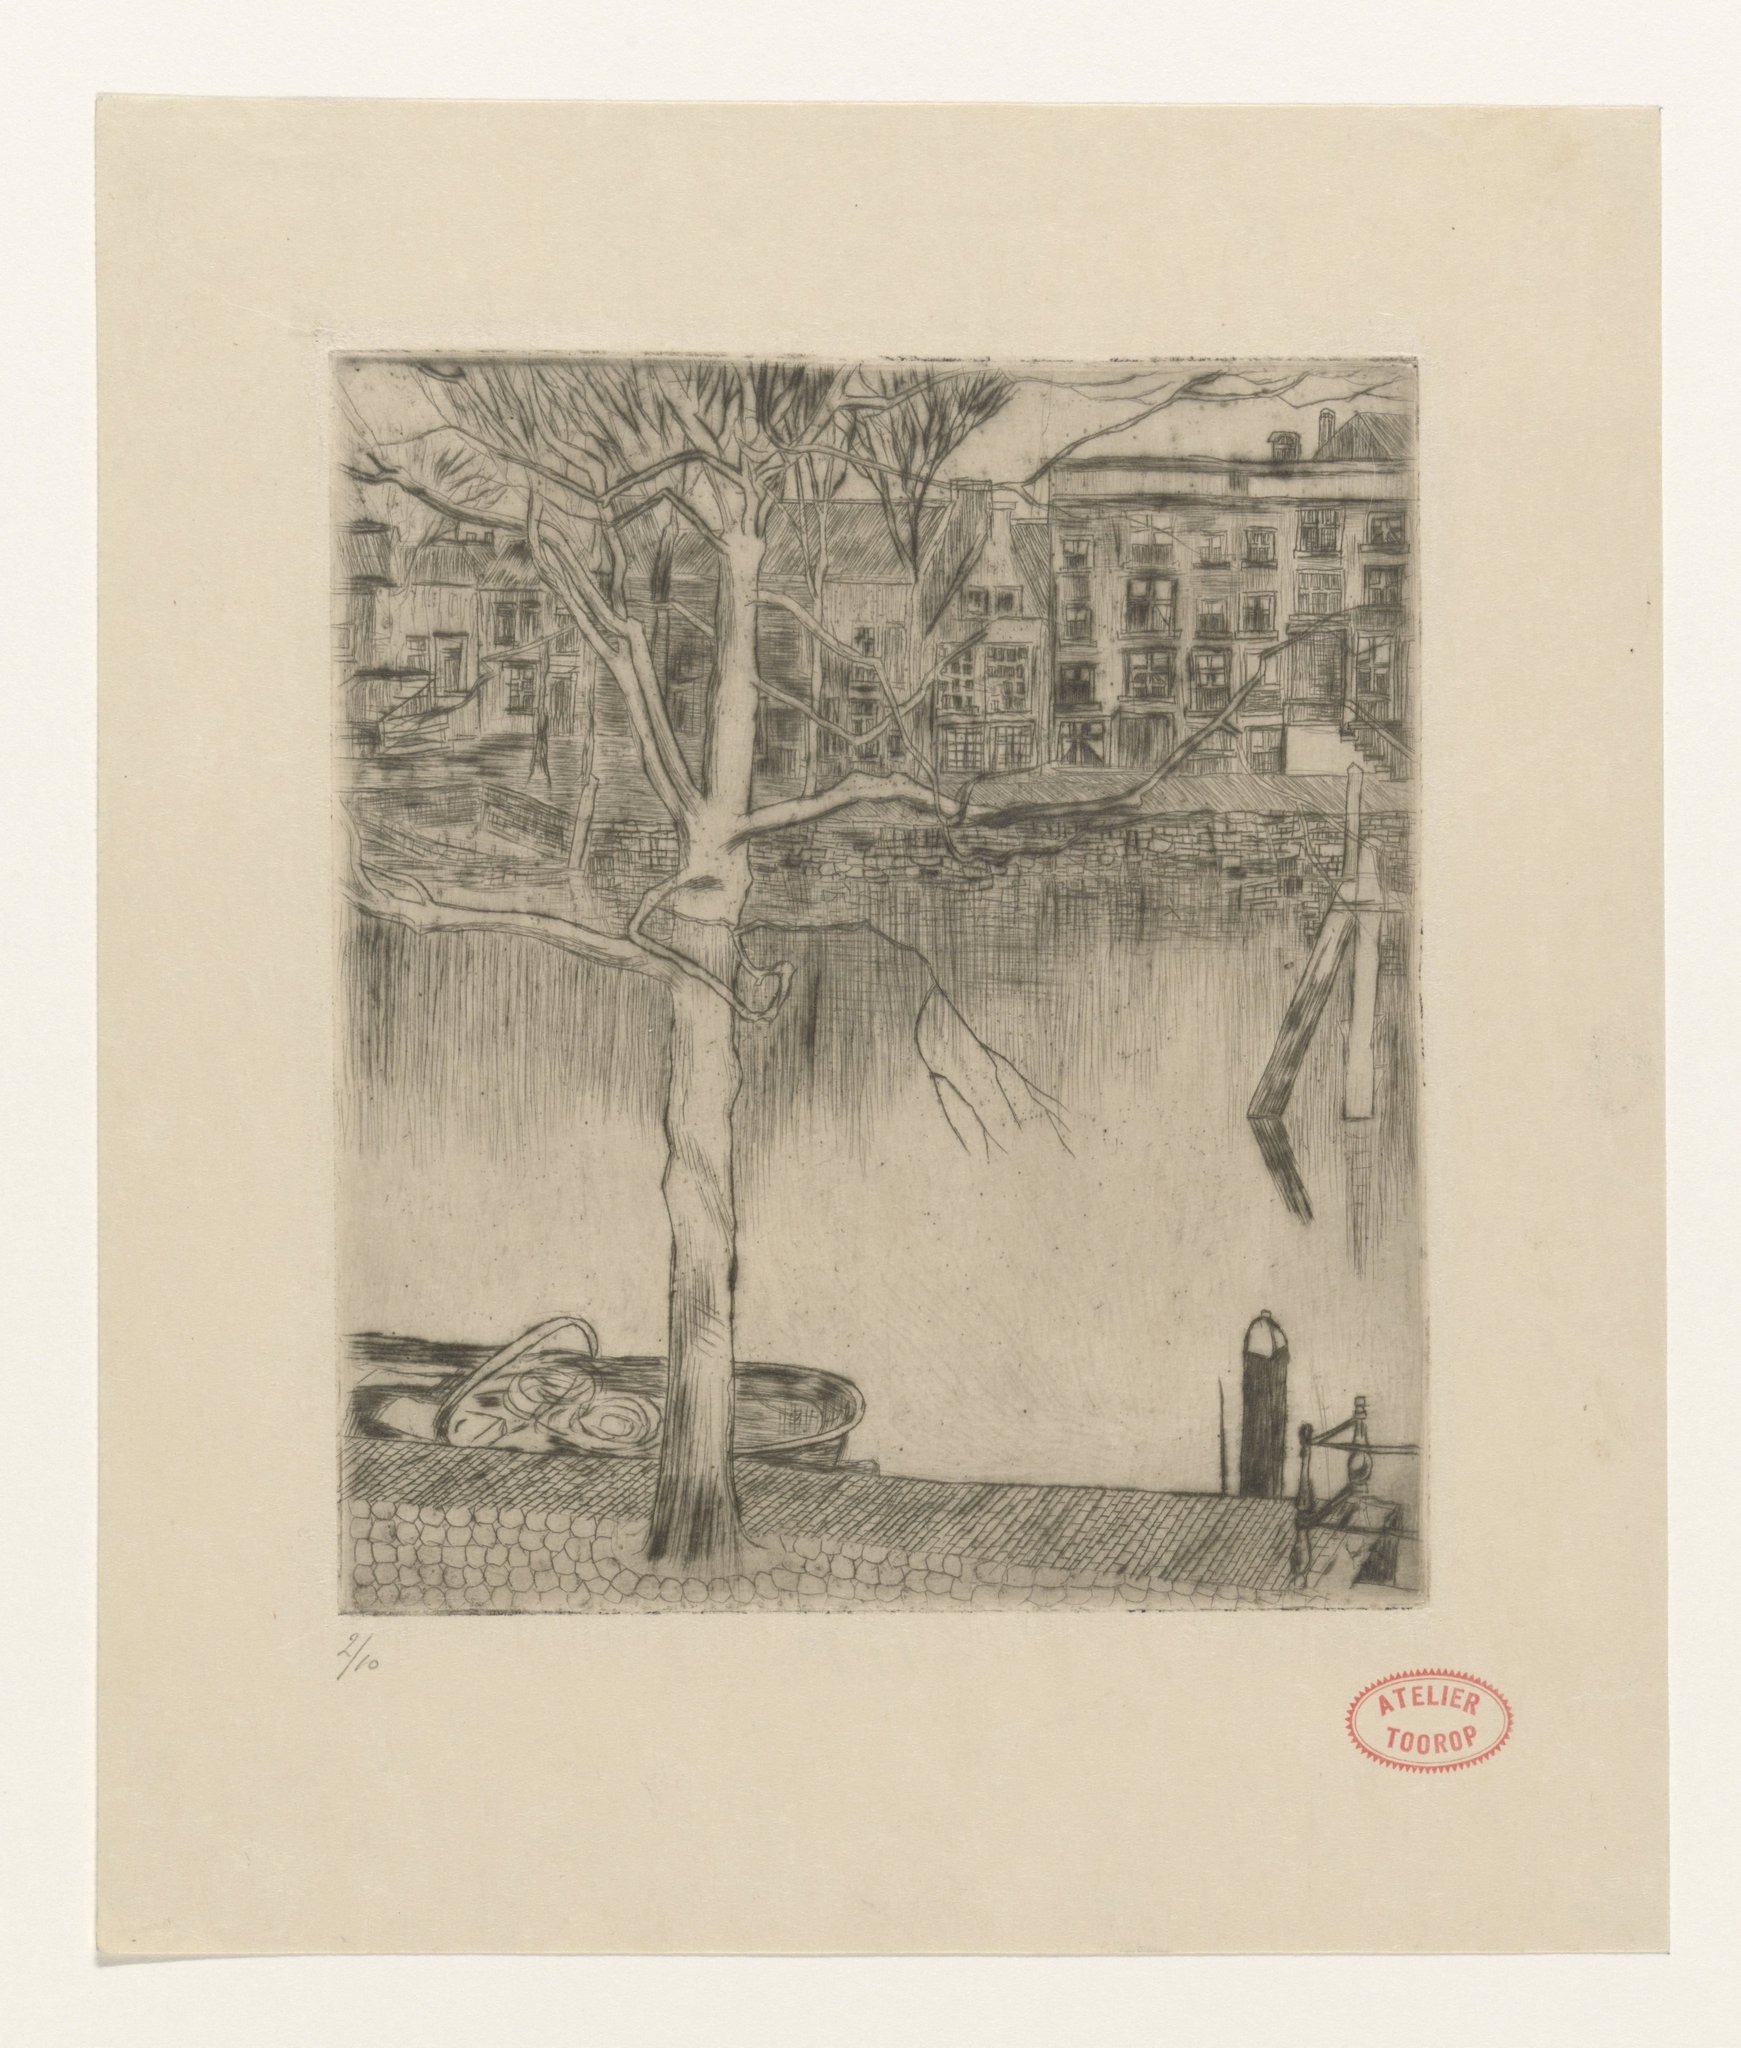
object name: print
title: Gracht in Dordrecht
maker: jan toorop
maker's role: draughtsman, painter, print maker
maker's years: 1858-1928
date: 1899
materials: paper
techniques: drypoint, intaglio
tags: canals, waters (in city), dordrecht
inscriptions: collector's mark: Lugt 2760, collector's mark: Lugt 2228, collector's mark: Lugt 2401a